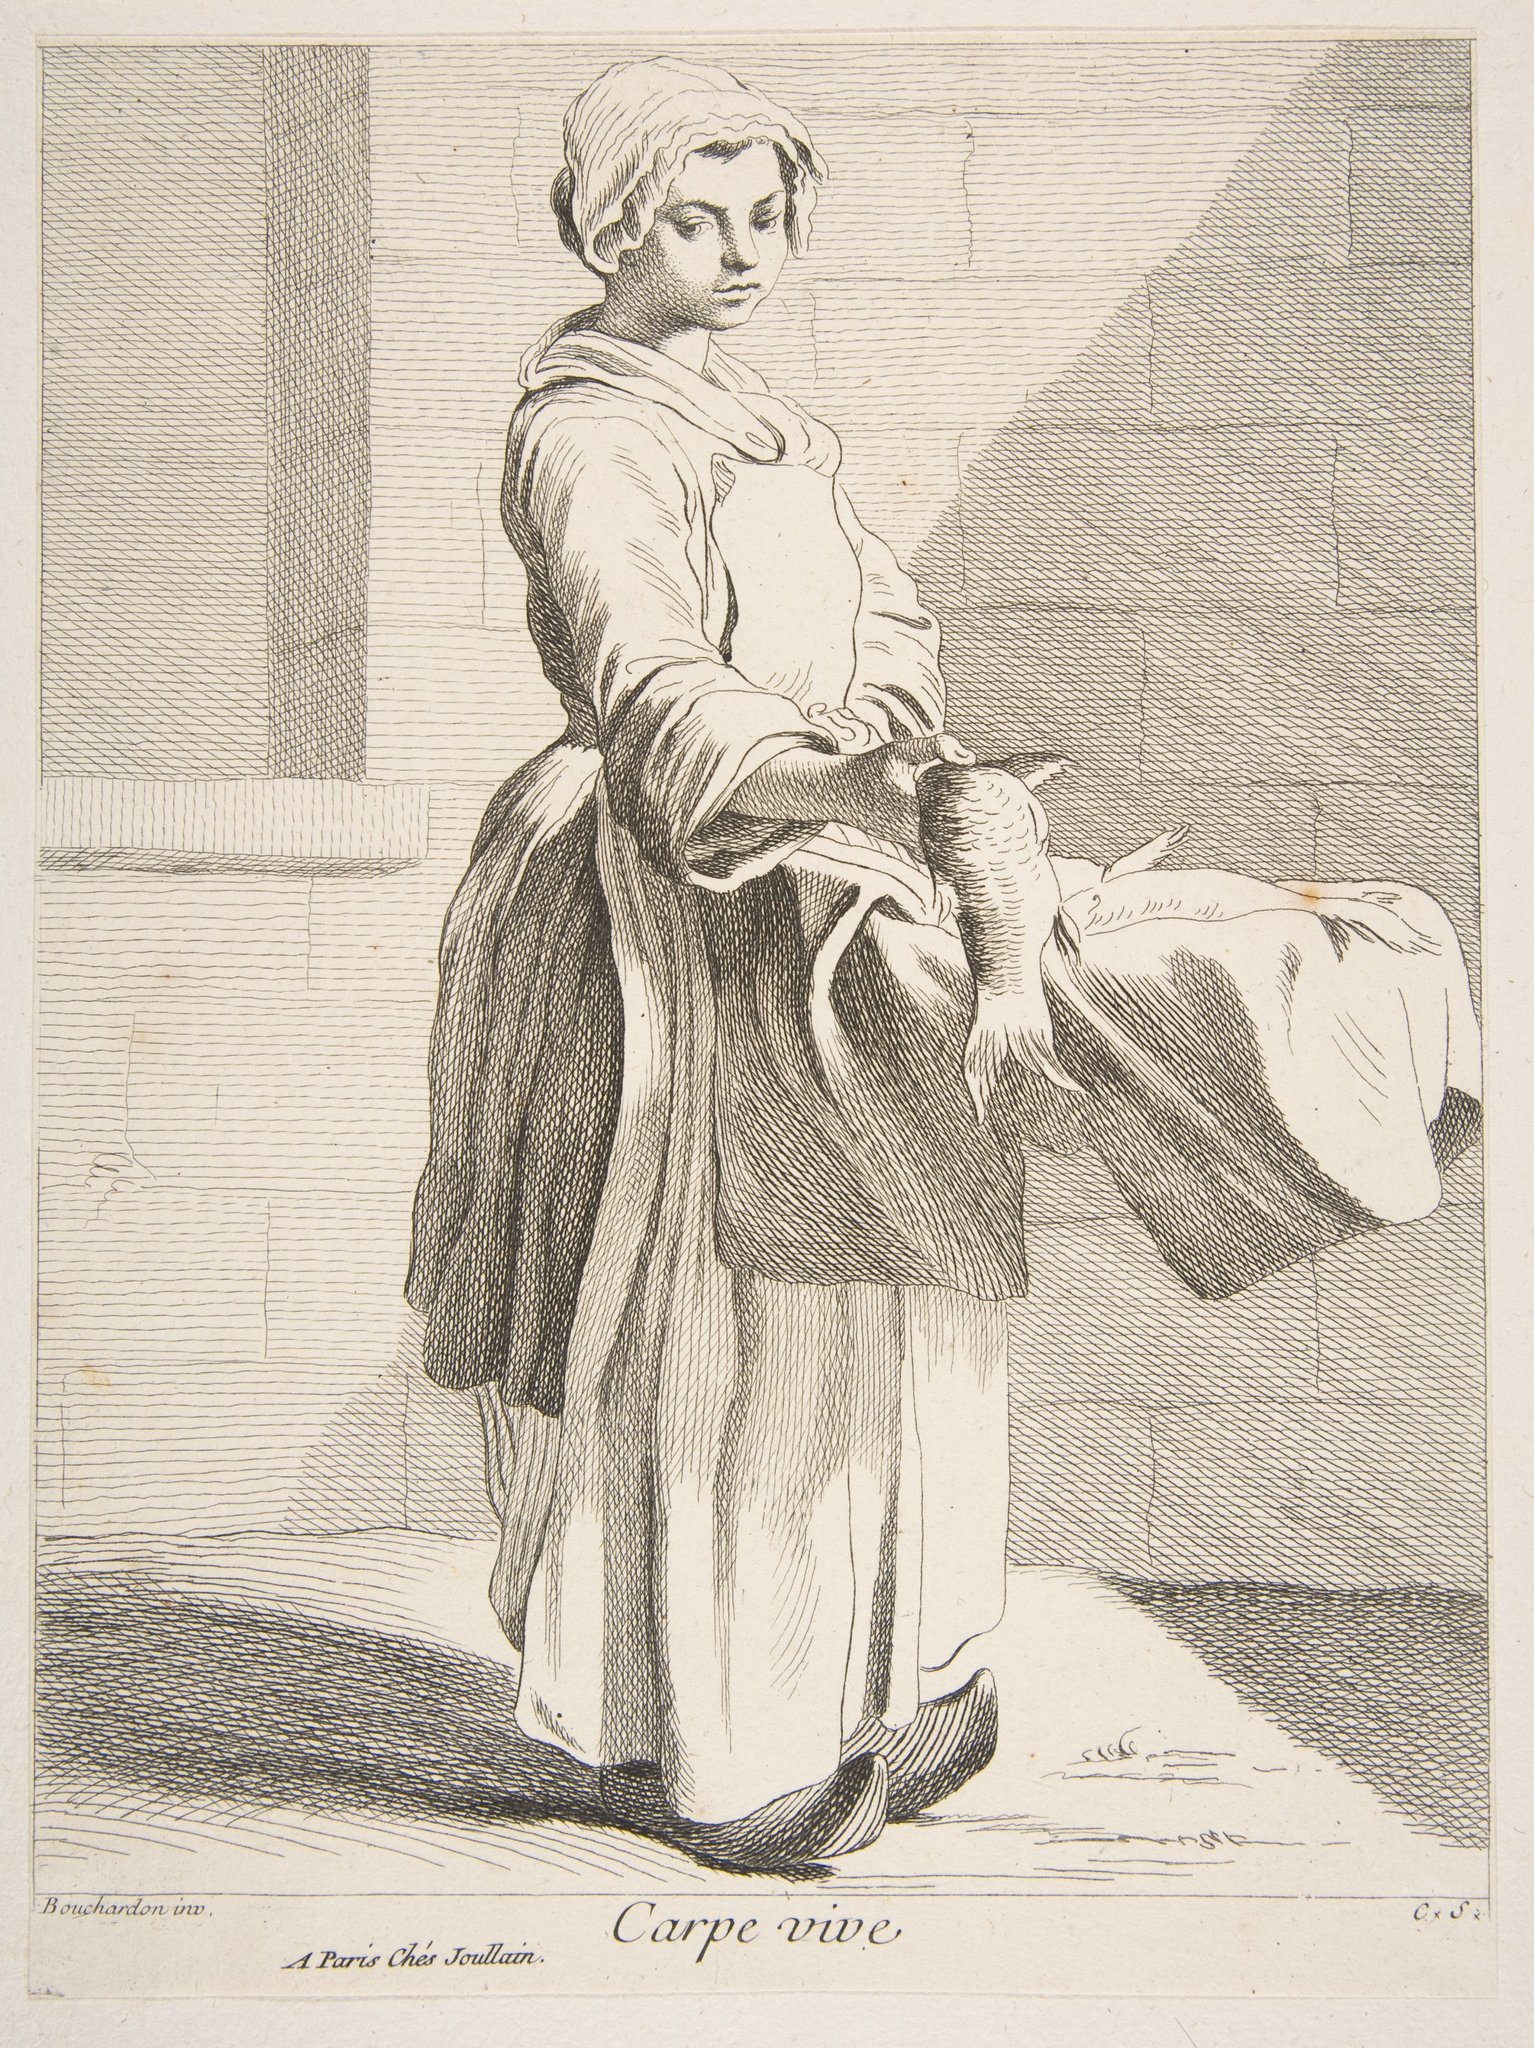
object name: print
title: Fish Vendor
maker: anne claude philippe de tubières, comte de caylus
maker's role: artist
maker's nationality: french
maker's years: 1692-1765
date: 1738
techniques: engraving, etching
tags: women,fish